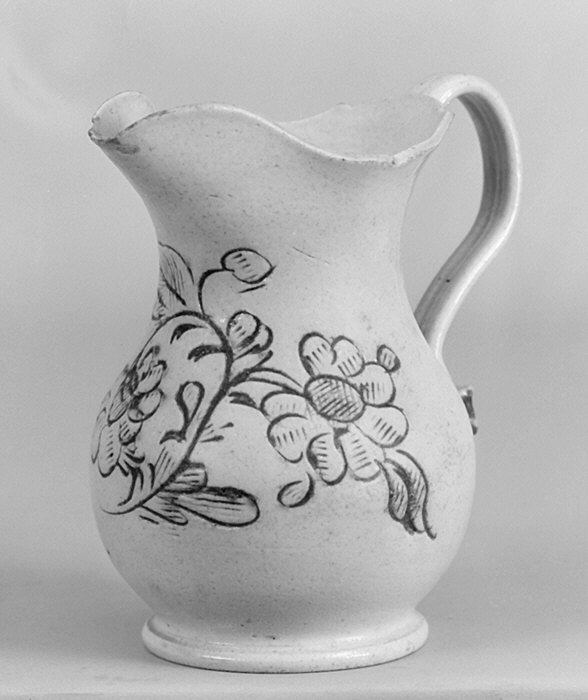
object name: cream jug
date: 1750-1770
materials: stoneware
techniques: salt glaze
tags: flowers